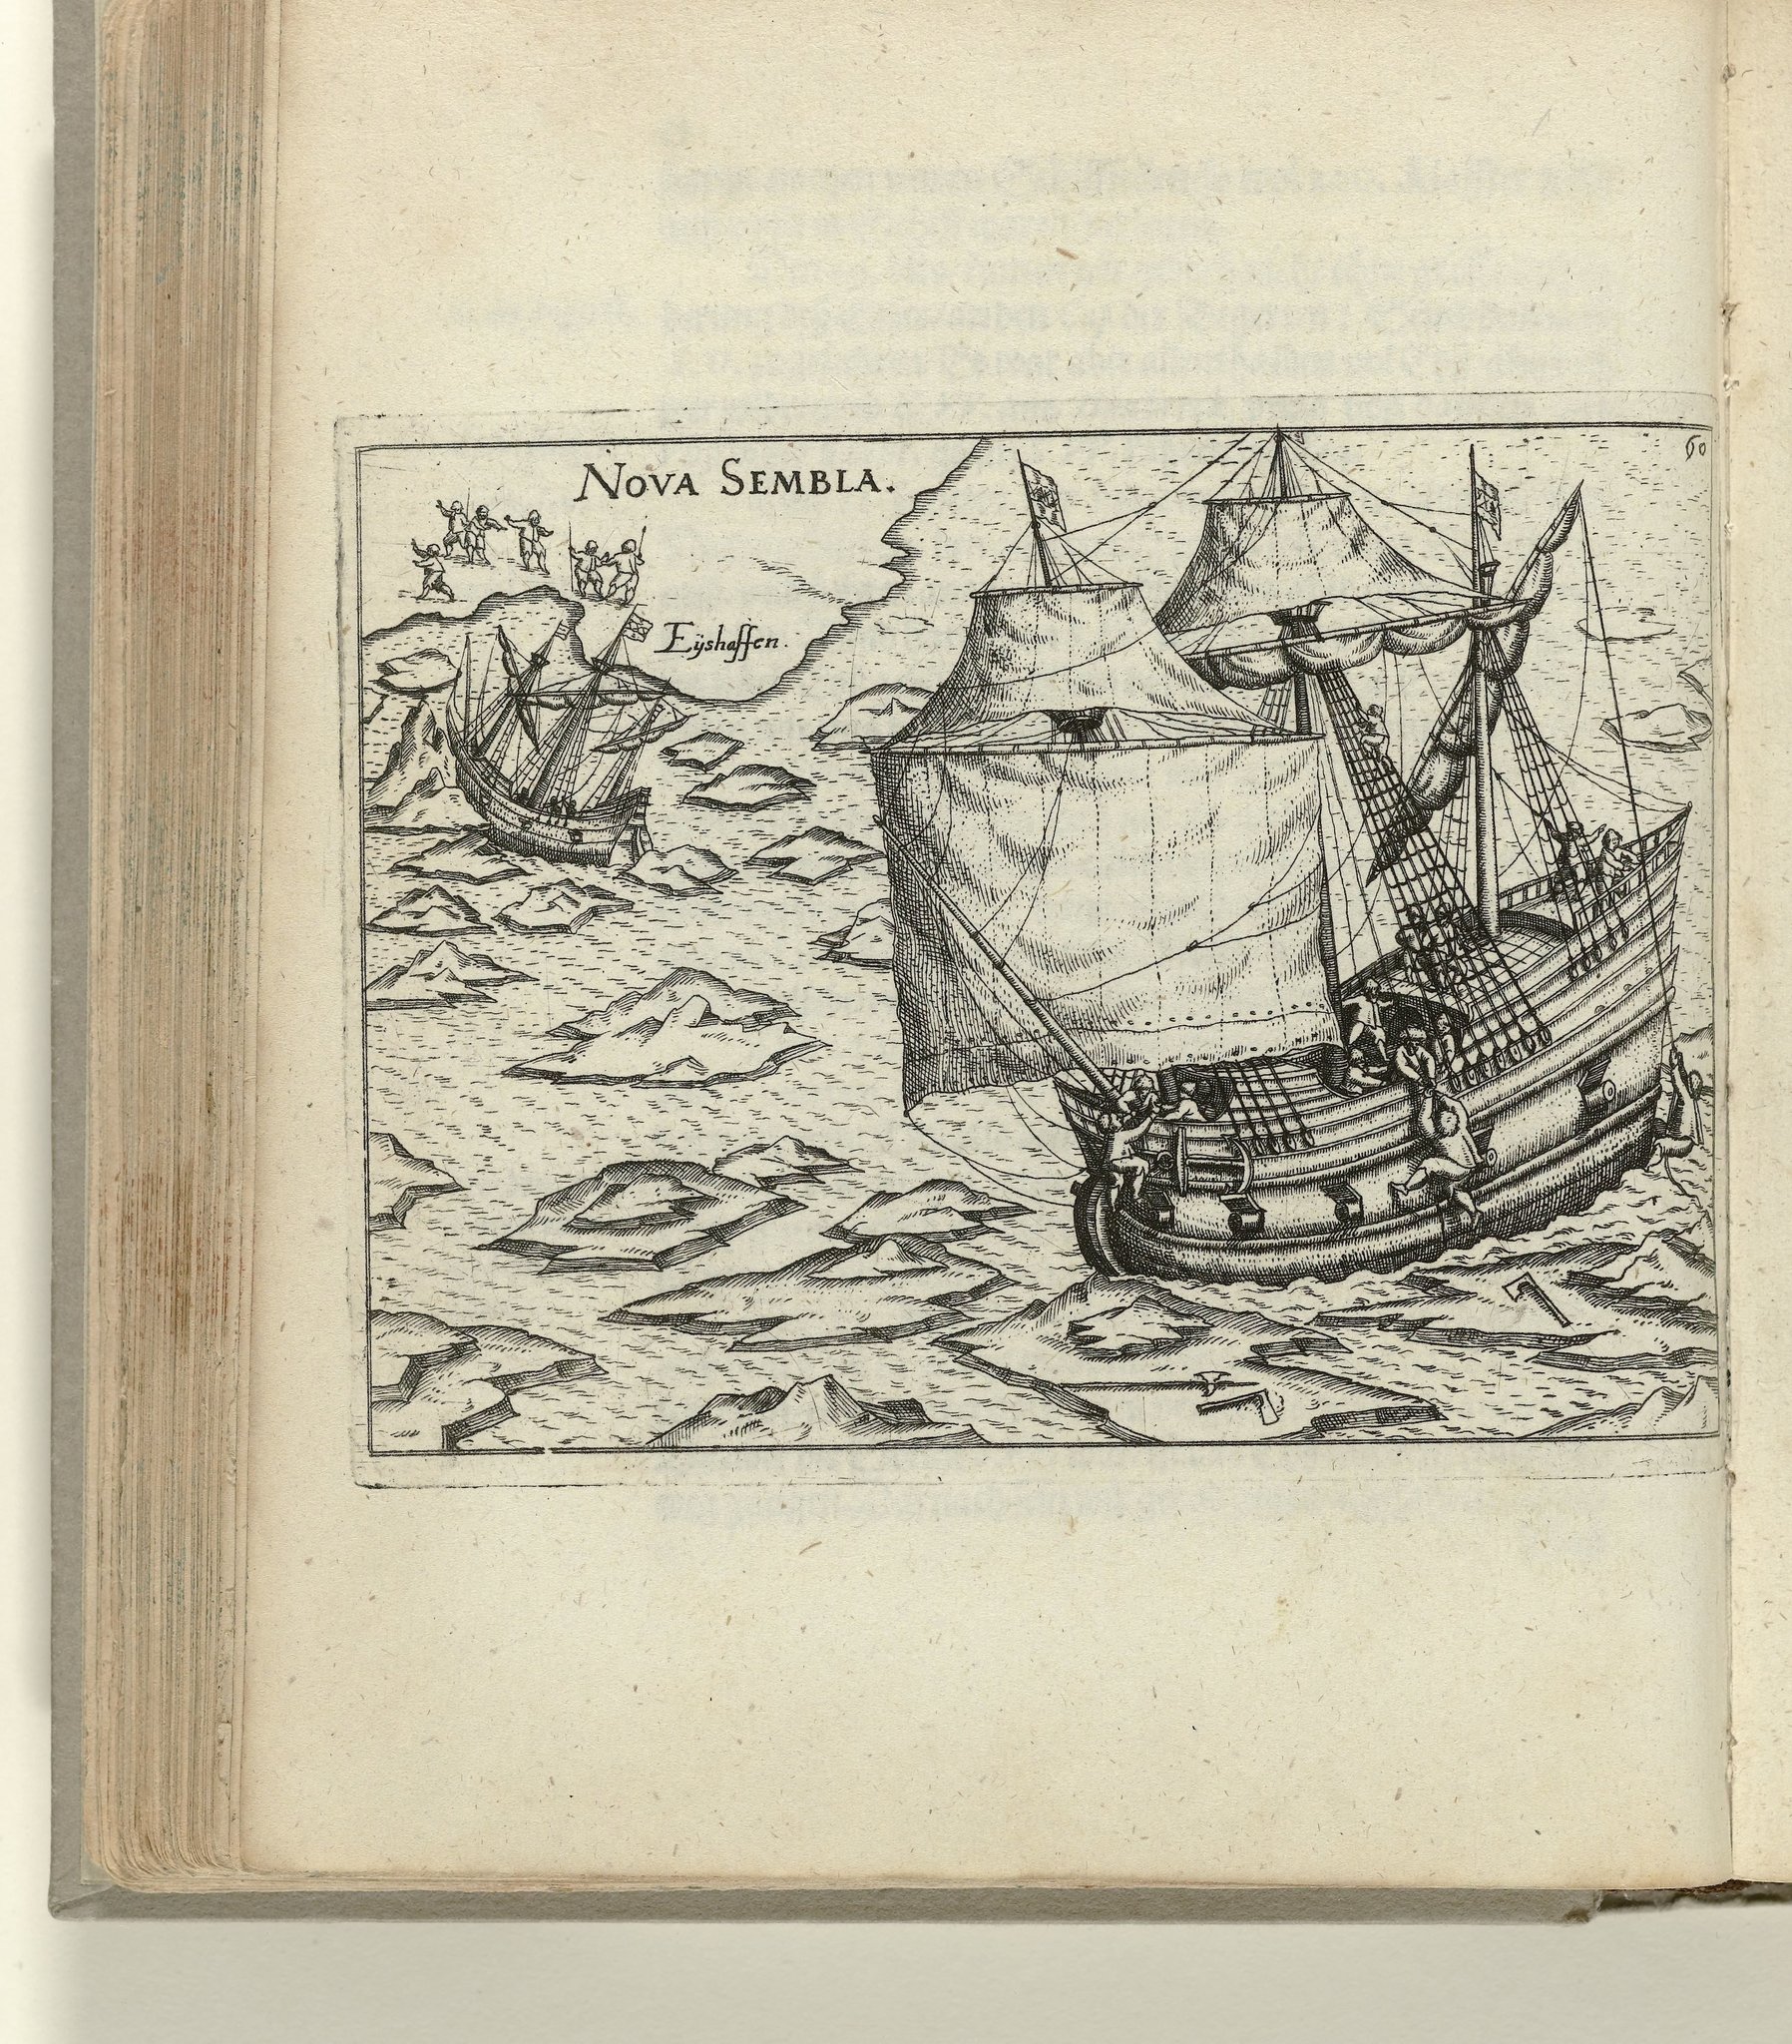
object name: print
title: Het schip raakt vast in het ijs, 1596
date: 1598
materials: paper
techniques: engraving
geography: nuremberg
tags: willem barendsz., jacob van heemskerck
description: Op de voorgrond klimmen bemanningsleden overboord om het ijs rond het schip los te hakken. Op de achtergrond is het schip inmiddels door het ijs ingesloten in IJshaven en is een deel van de bemanning aan land te zien. Tegenover pagina 60 in: 'Warhafftige Relation. Der dreyen newen unerhörten seltzamen Schiffart so die Holländischen und Seeländischen Schiff....Anno 1594, 1595 und 1596 verricht' (1598).